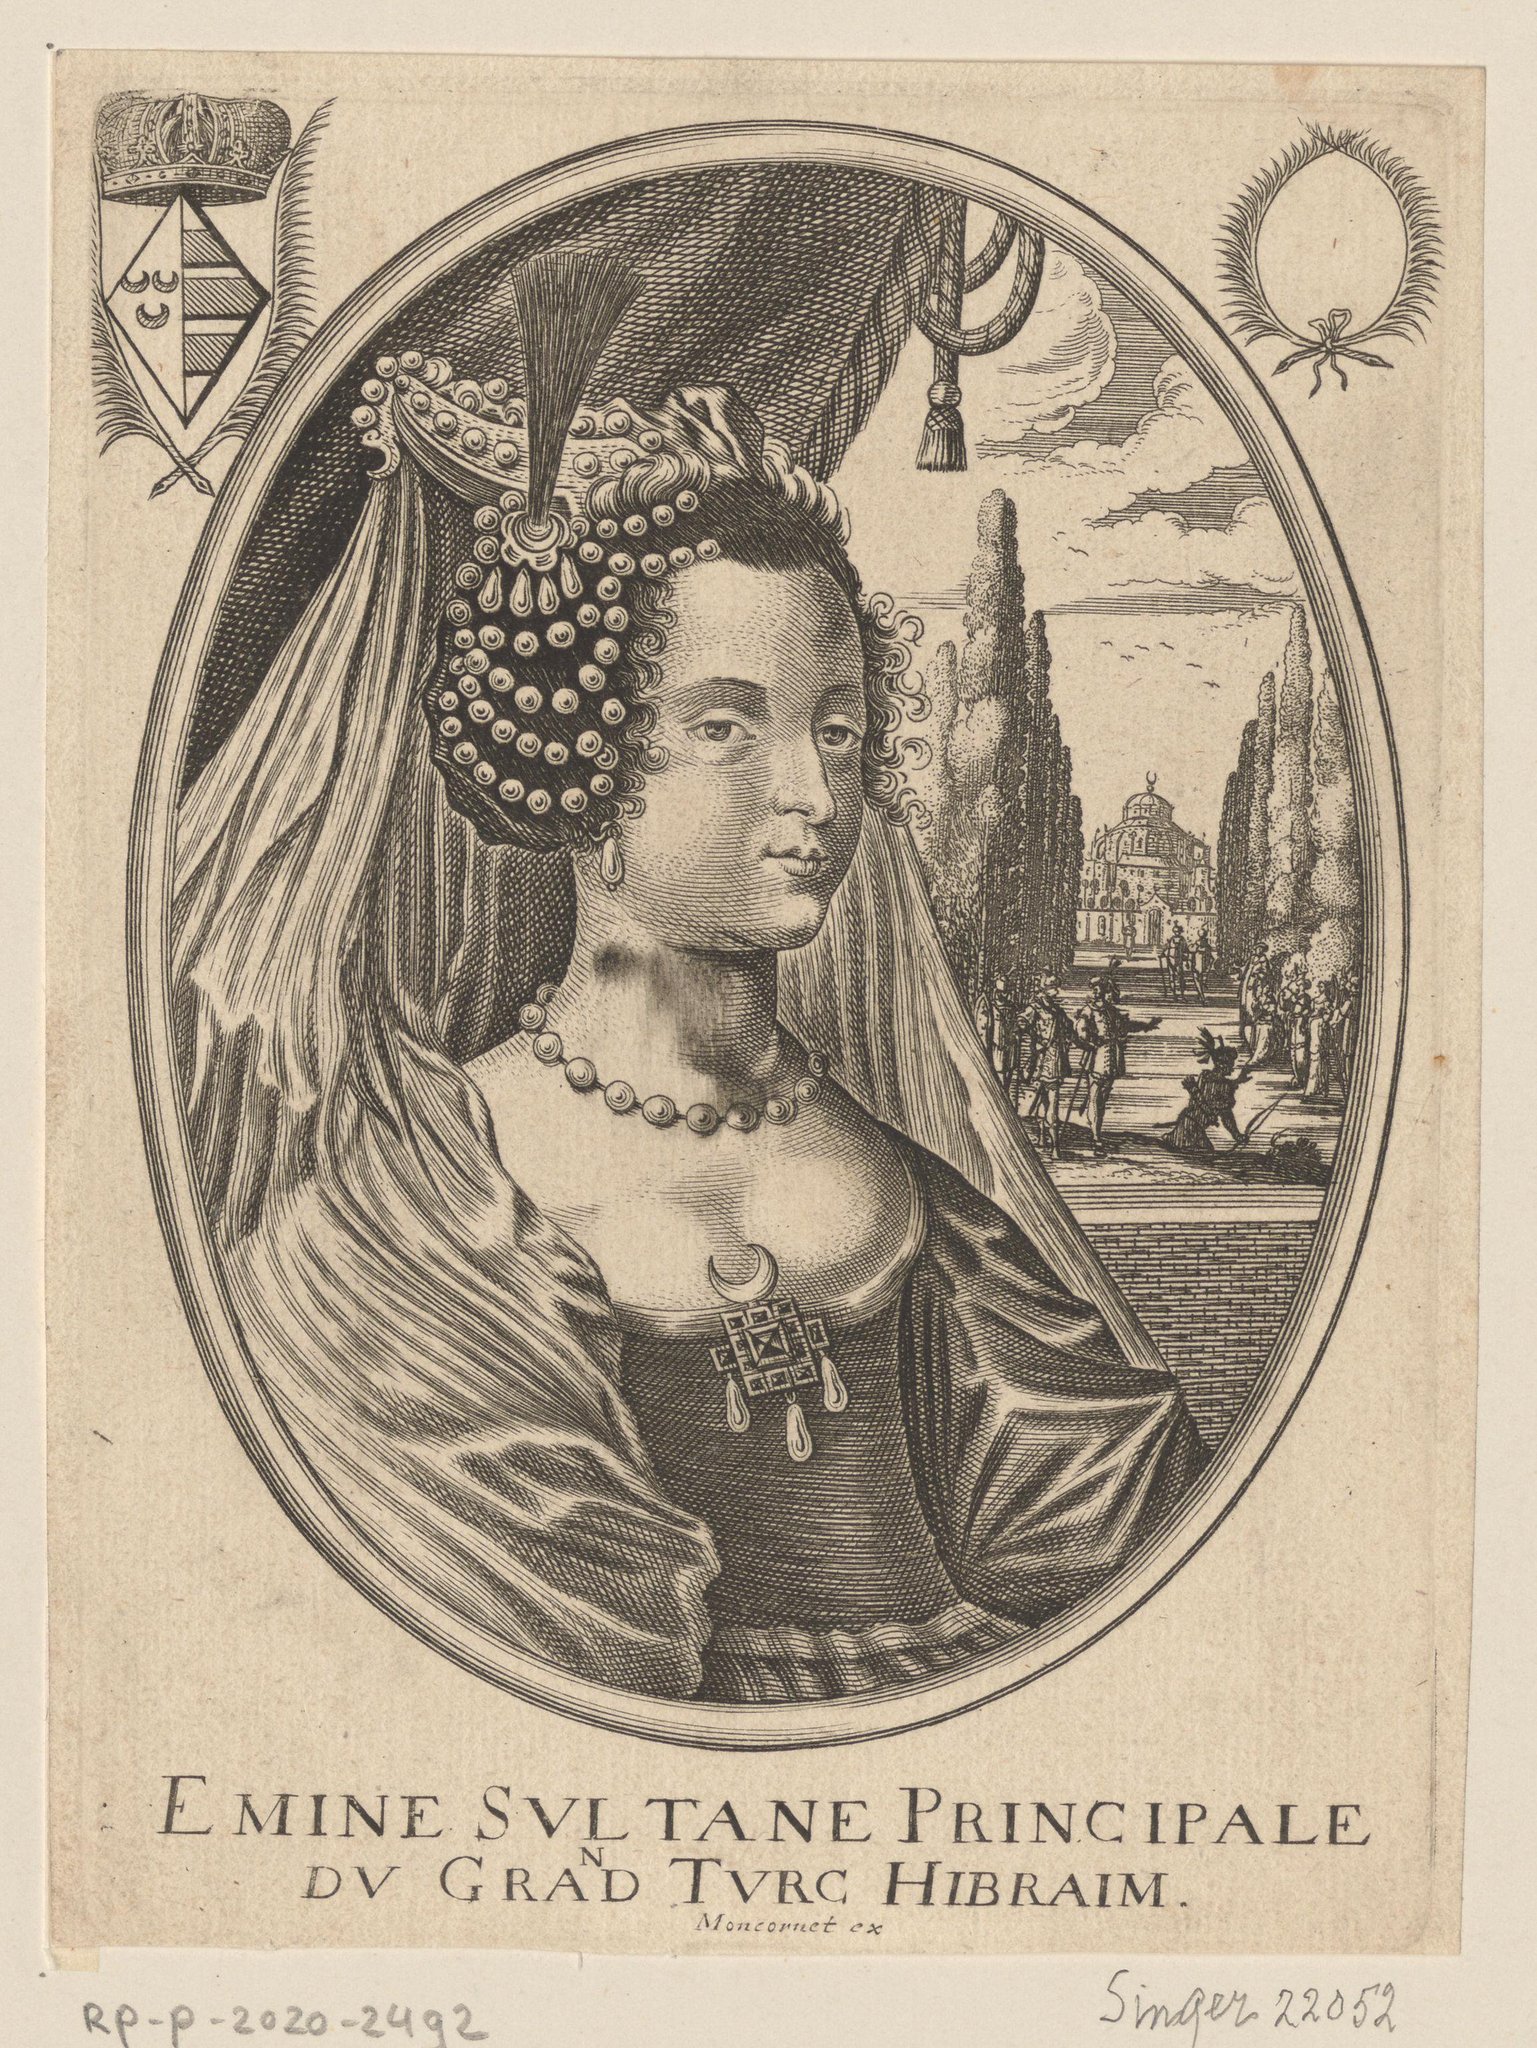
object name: print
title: Portretten uitgegeven door Balthazar Moncornet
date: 1652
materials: paper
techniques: engraving, etching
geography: paris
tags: trees: cypress, archer's weapons: bow and arrow, historical persons - bb - woman, pearl; pearl necklace, armorial bearing, heraldry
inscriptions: collector's mark: Lugt 2228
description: Onderdeel van een serie portretten, in catalogi bekend als 'Recueil de portraits des rois, princes et seigneurs français et étrangers'. Zie Van Someren.